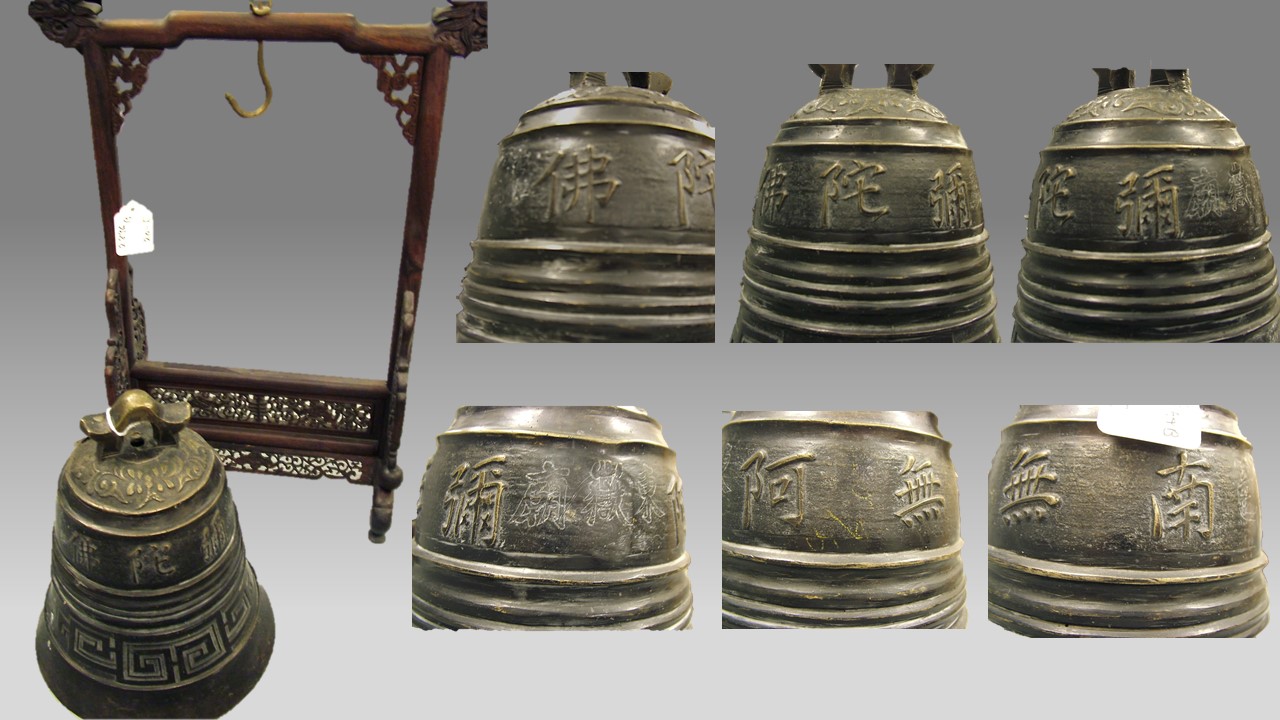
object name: temple bell and stand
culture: chinese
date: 1825-1889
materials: bronze, wood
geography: china